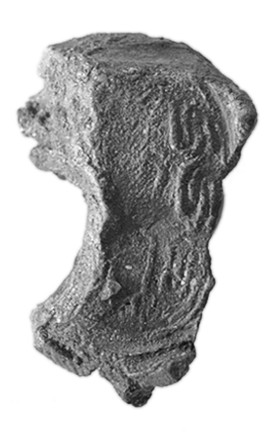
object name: sealing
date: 1981-1640 BCE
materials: mud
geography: egypt